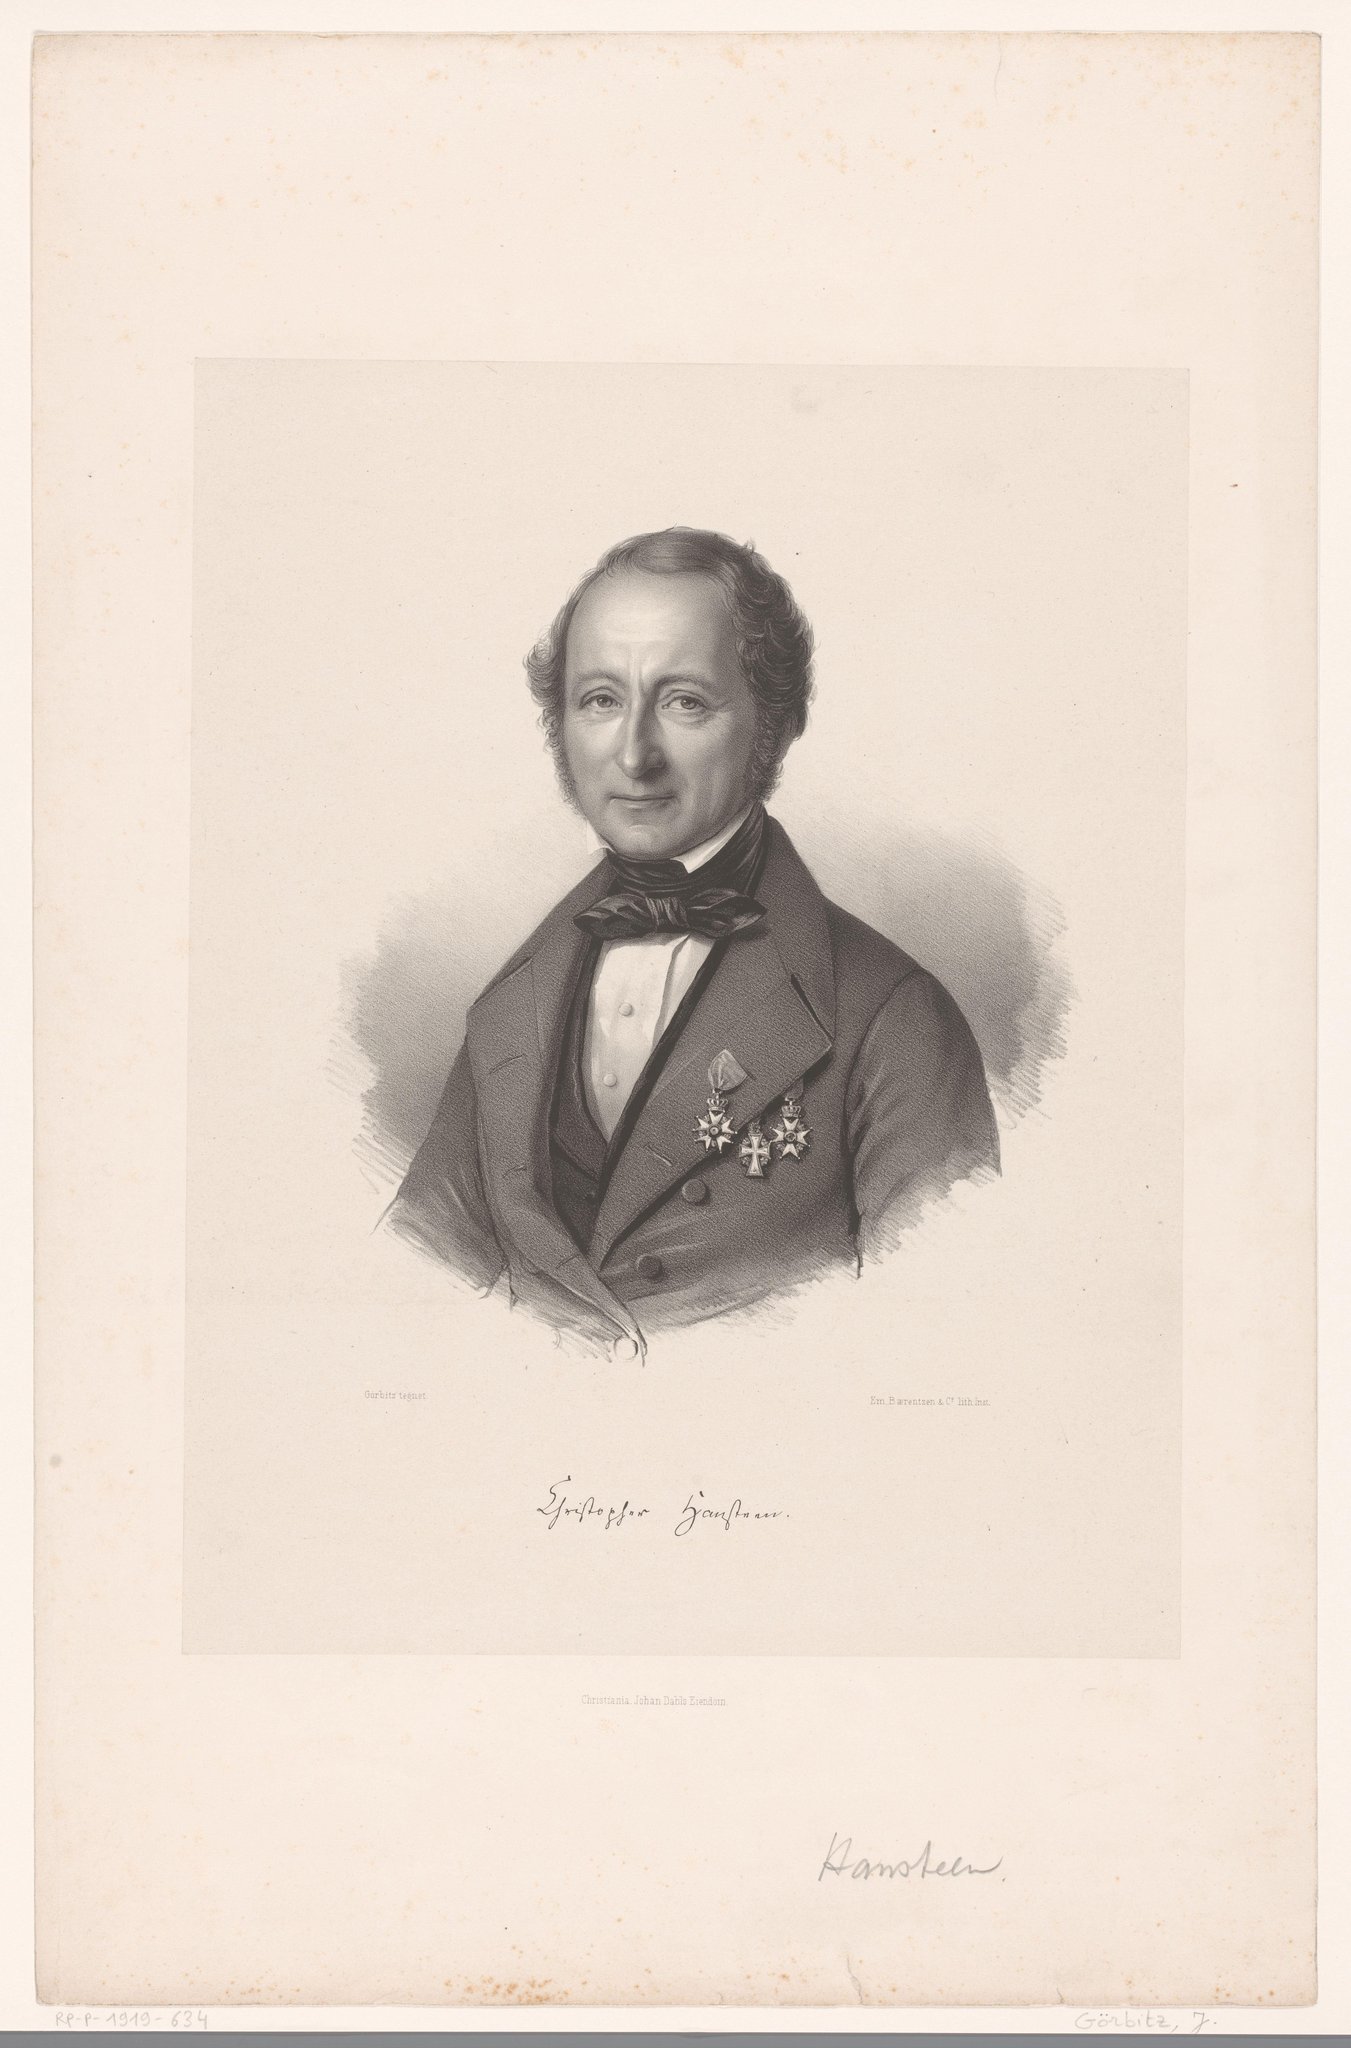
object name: print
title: Portret van Christopher Hansteen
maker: johan görbitz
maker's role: painter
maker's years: 1782-1853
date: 1809-1853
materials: paper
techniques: lithograph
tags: physicist, historical persons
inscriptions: signature: ‘Görbitz tegnet.’, signature: ‘Em. Baerentzen & Co lith.Inst.’, inscription: ‘Christopher Hansteen.’, inscription: ‘Christiania. Johan Dahls Eiendom.’, collector's mark: Lugt 2228